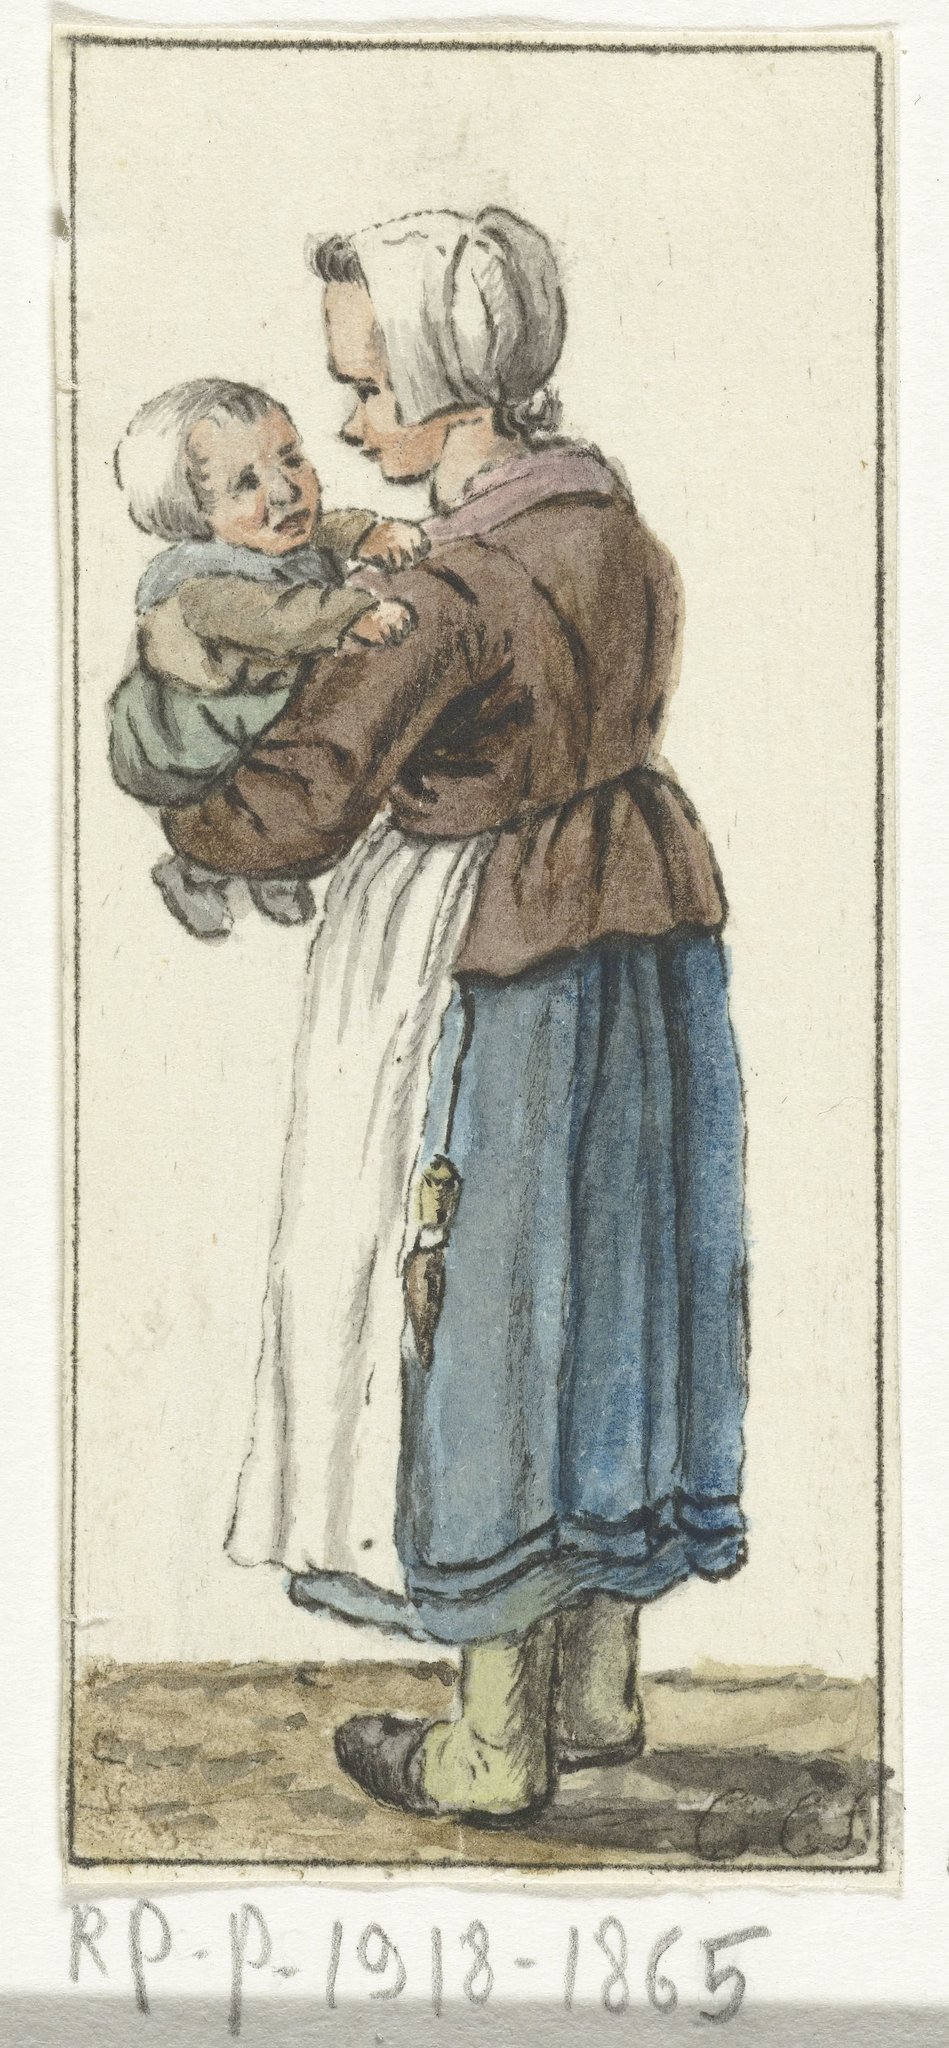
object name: print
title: Moeder met kind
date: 1779-1796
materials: paper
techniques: brush, etching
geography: leiden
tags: mother and daughter(s) (family group) (with number of daughters)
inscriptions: collector's mark: Lugt 2233